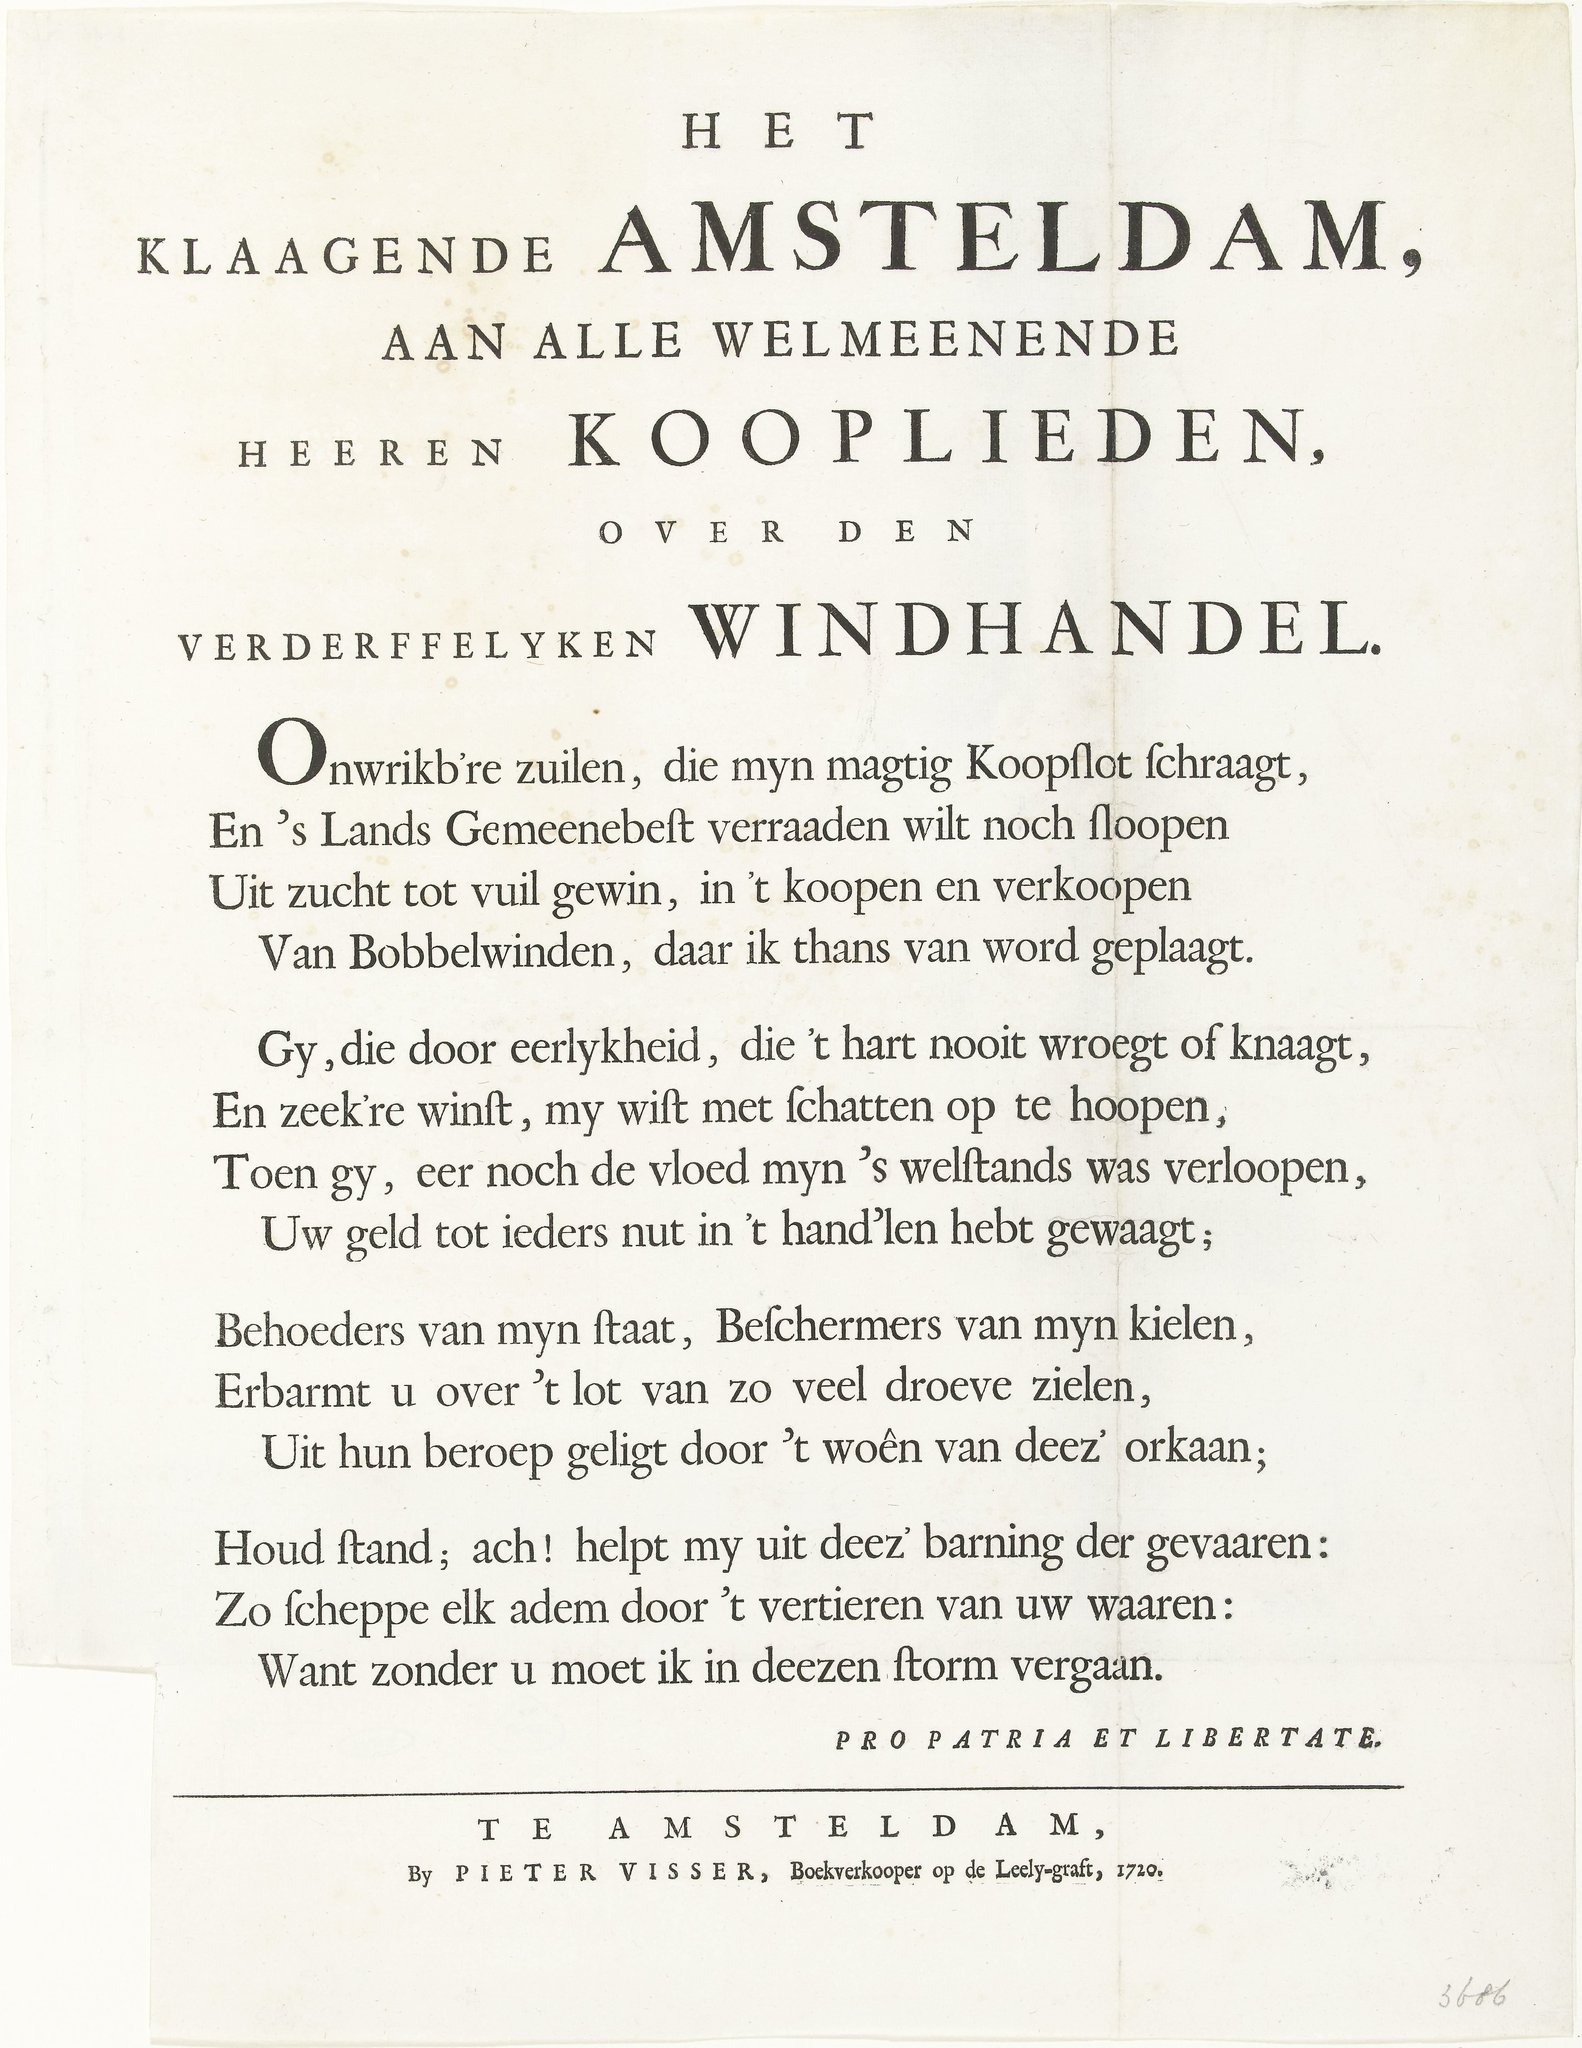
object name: text sheet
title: Het klaagende Amsteldam, aan alle welmeenende Heeren Kooplieden, over den verderffelyken windhandel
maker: pieter visser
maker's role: publisher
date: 1720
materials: paper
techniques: letterpress printing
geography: amsterdam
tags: amsterdam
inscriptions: collector's mark: Lugt 2228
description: Blad met een klaagvers van de stad Amsterdam aan de eerlijke kooplieden van de stad over de verderfelijke windhandelaren, 1720. Tekst in in vier verzen. Behoort tot de groep van gedrukte stukken toegevoegd aan de serie Tafereel der Dwaasheid met spotprenten op de Windhandel of Actiehandel van 1720.